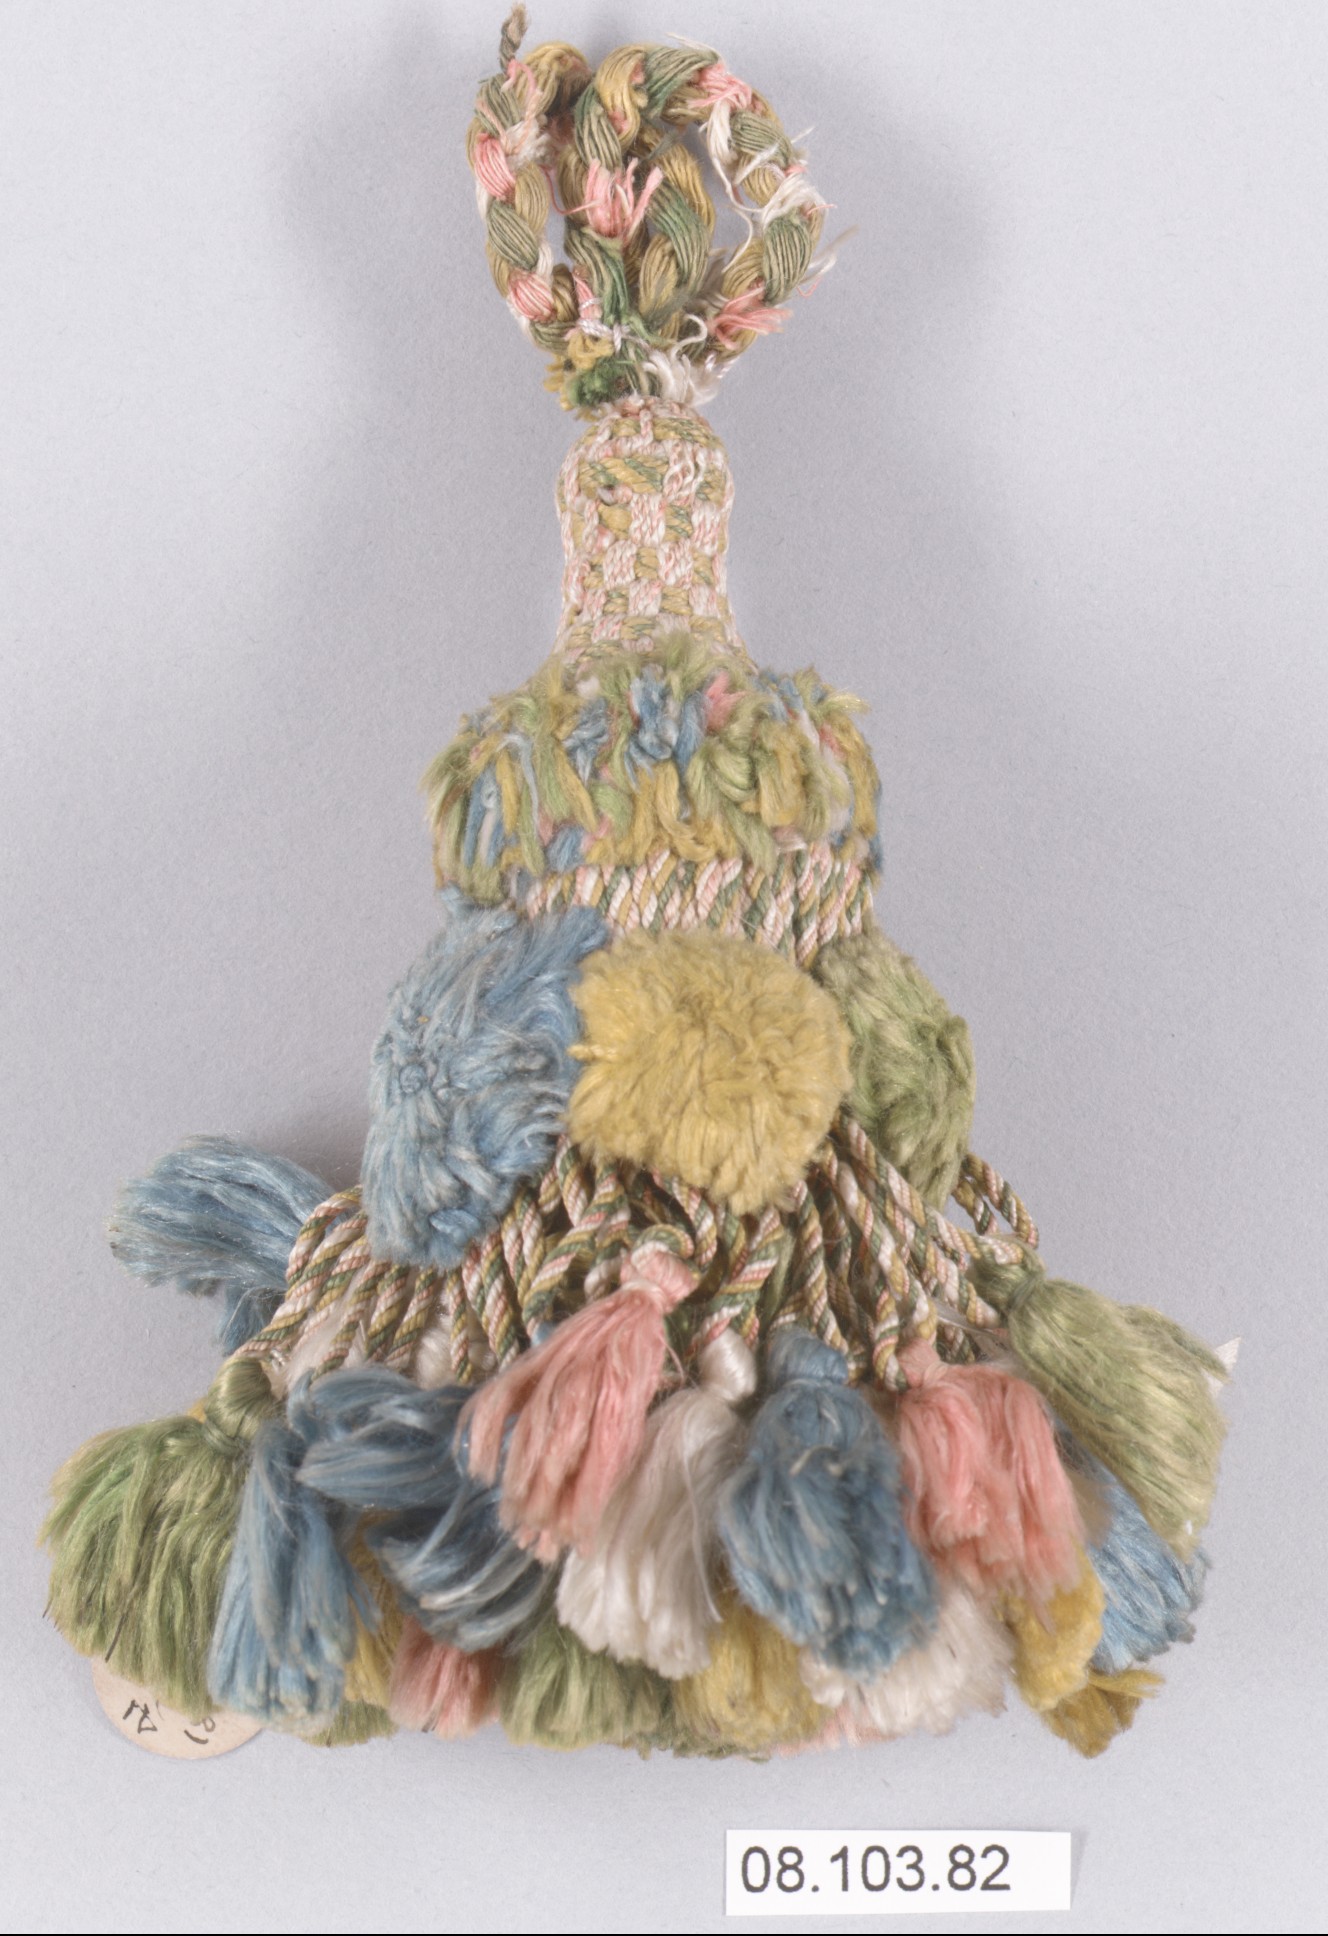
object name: tassel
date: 1701-1800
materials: cotton, silk